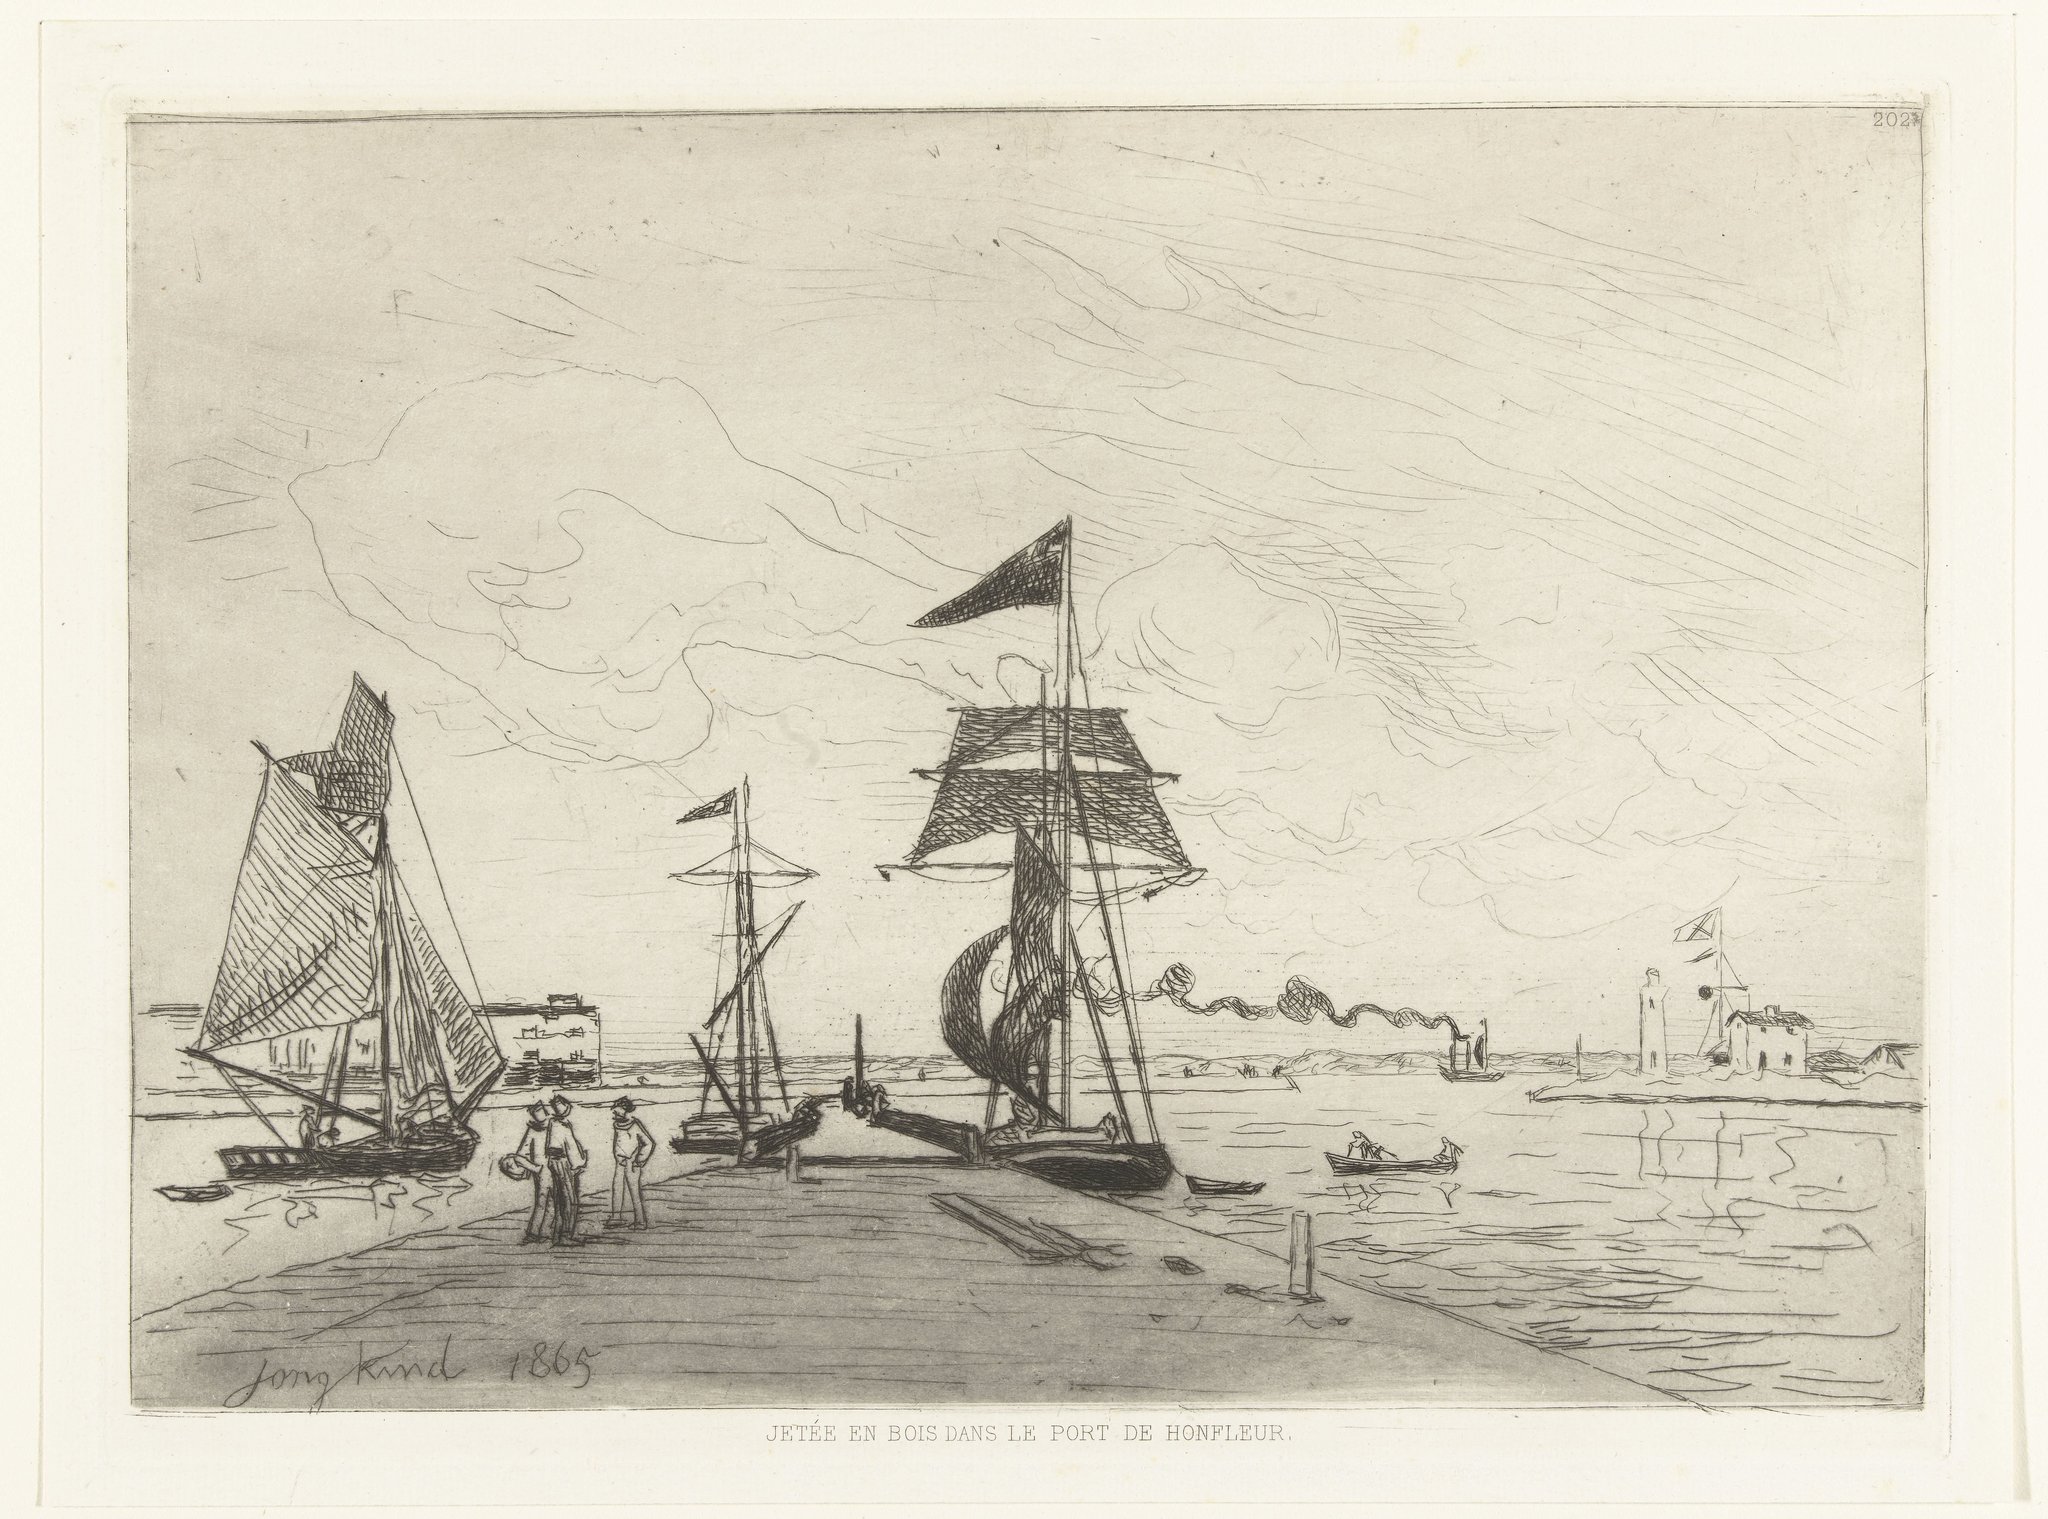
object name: print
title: Aanlegsteiger bij Honfleur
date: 1865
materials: paper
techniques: etching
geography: honfleur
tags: harbour, ships (in general)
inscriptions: collector's mark: Lugt 2228a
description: Een steiger in de haven van Honfleur, waaromheen drie zeilschepen liggen. Rechts op de achtergrond een vuurtoren, links een aantal huizen.